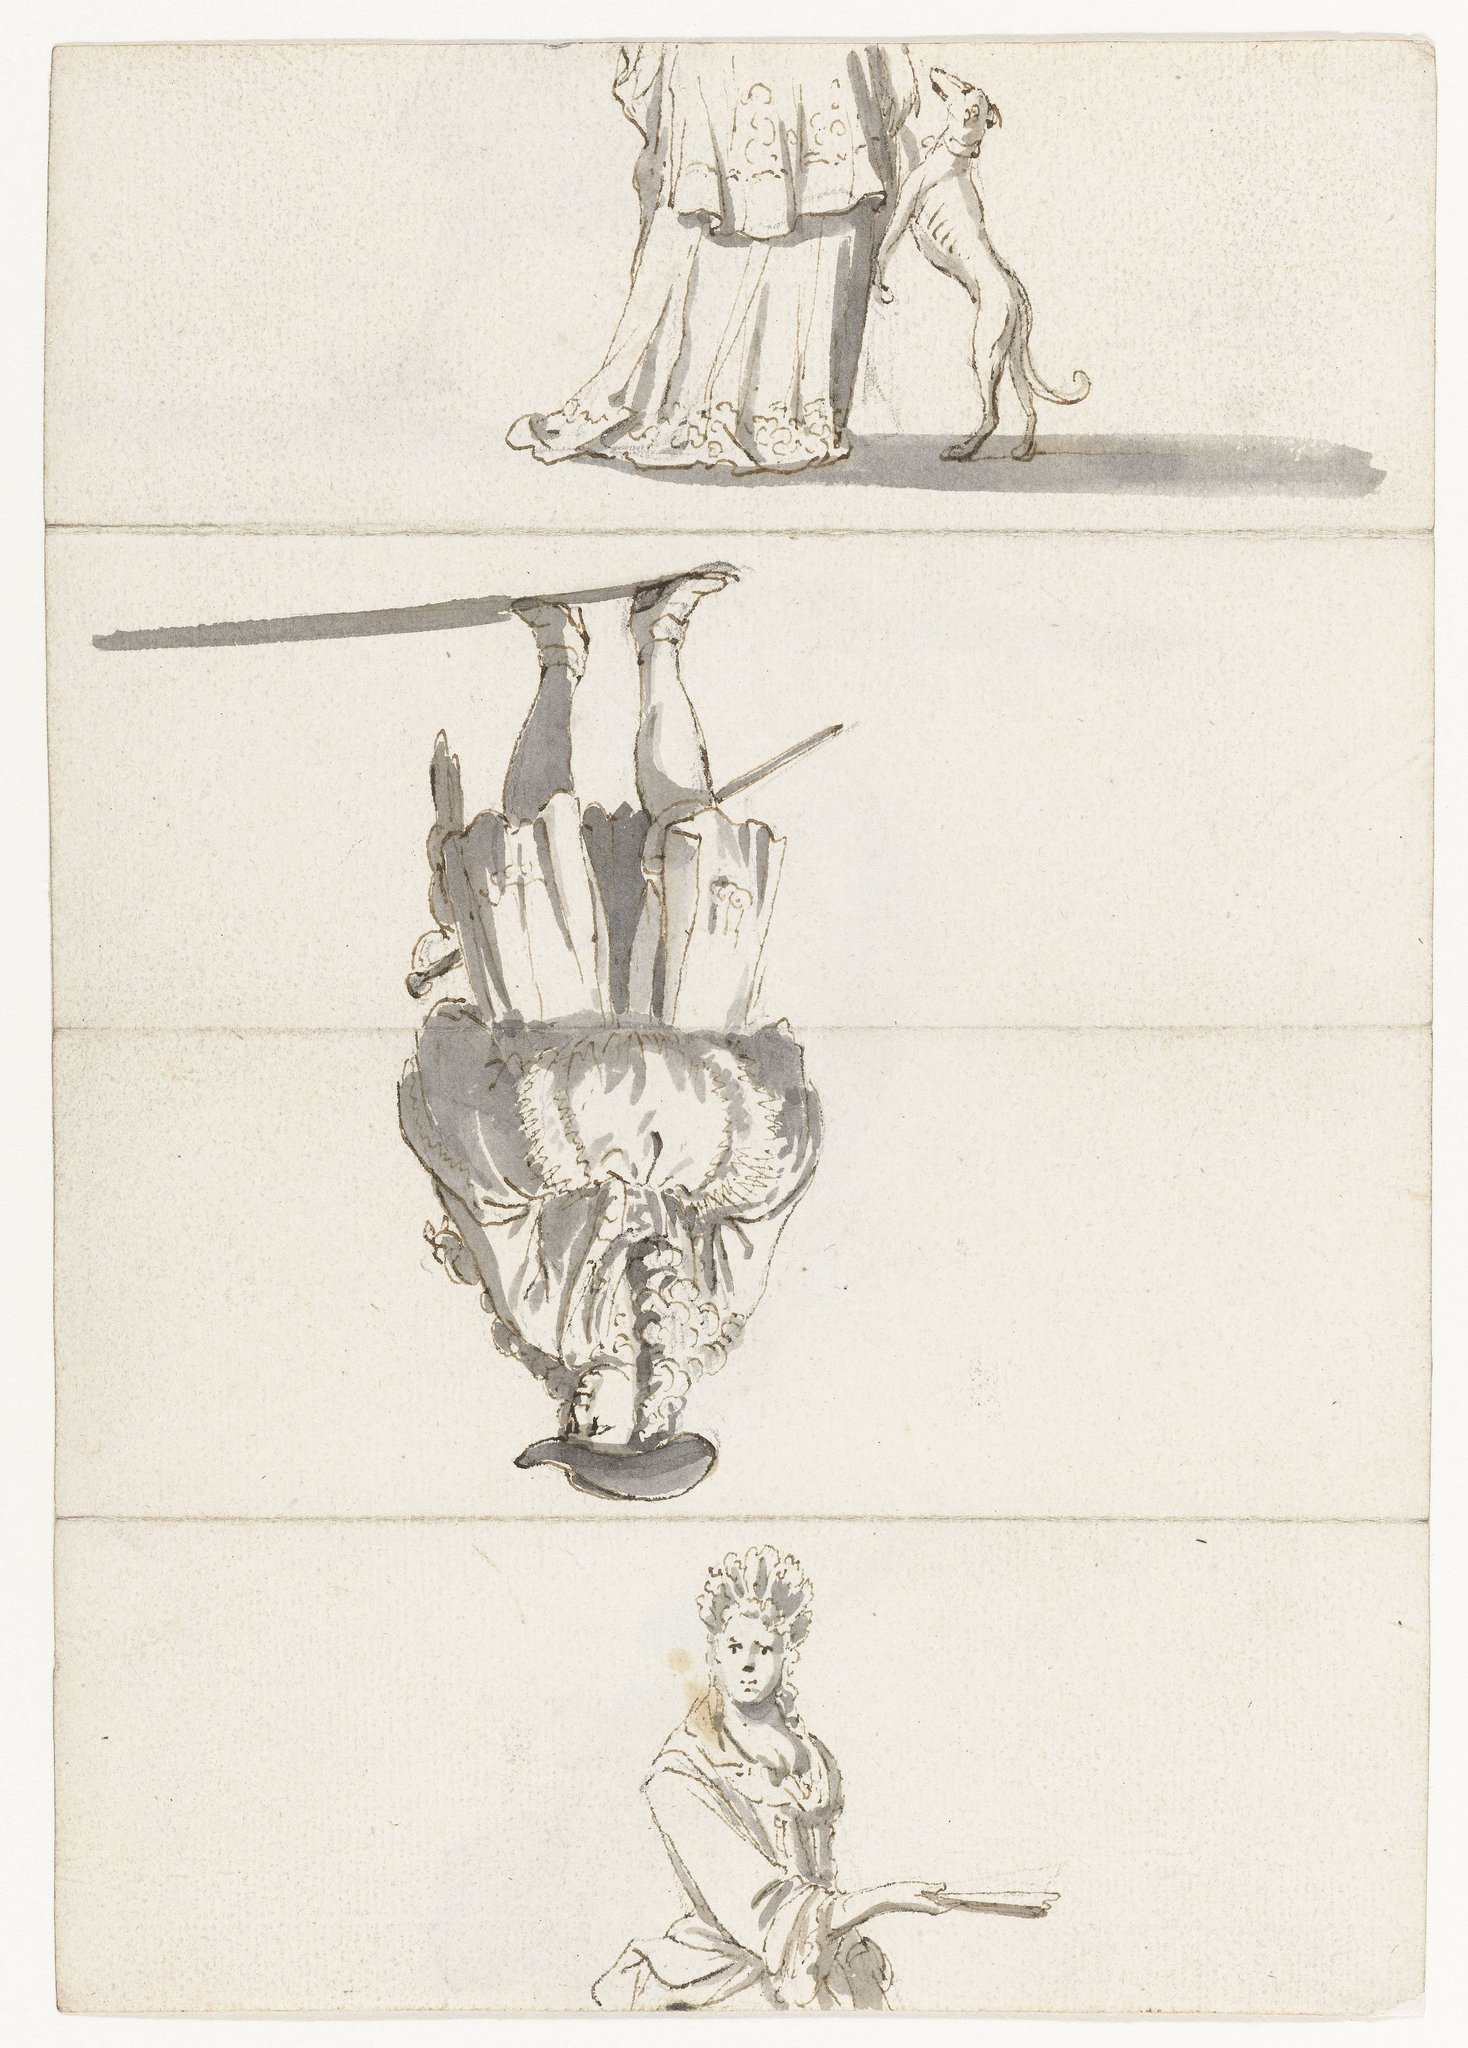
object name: drawing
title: Vouwblad met figuurstudies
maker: ludolf bakhuysen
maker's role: draughtsman, print maker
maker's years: 1631-1708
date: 1695-1705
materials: chalk, graphite, ink, paper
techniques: brush, pen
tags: standing figure, standing figure - aa - female human figure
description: Vouwblad met aan de keerzijde een staande vrouw met een vogel op de hand en het boven- en onderlichaam van een schaatsende man.